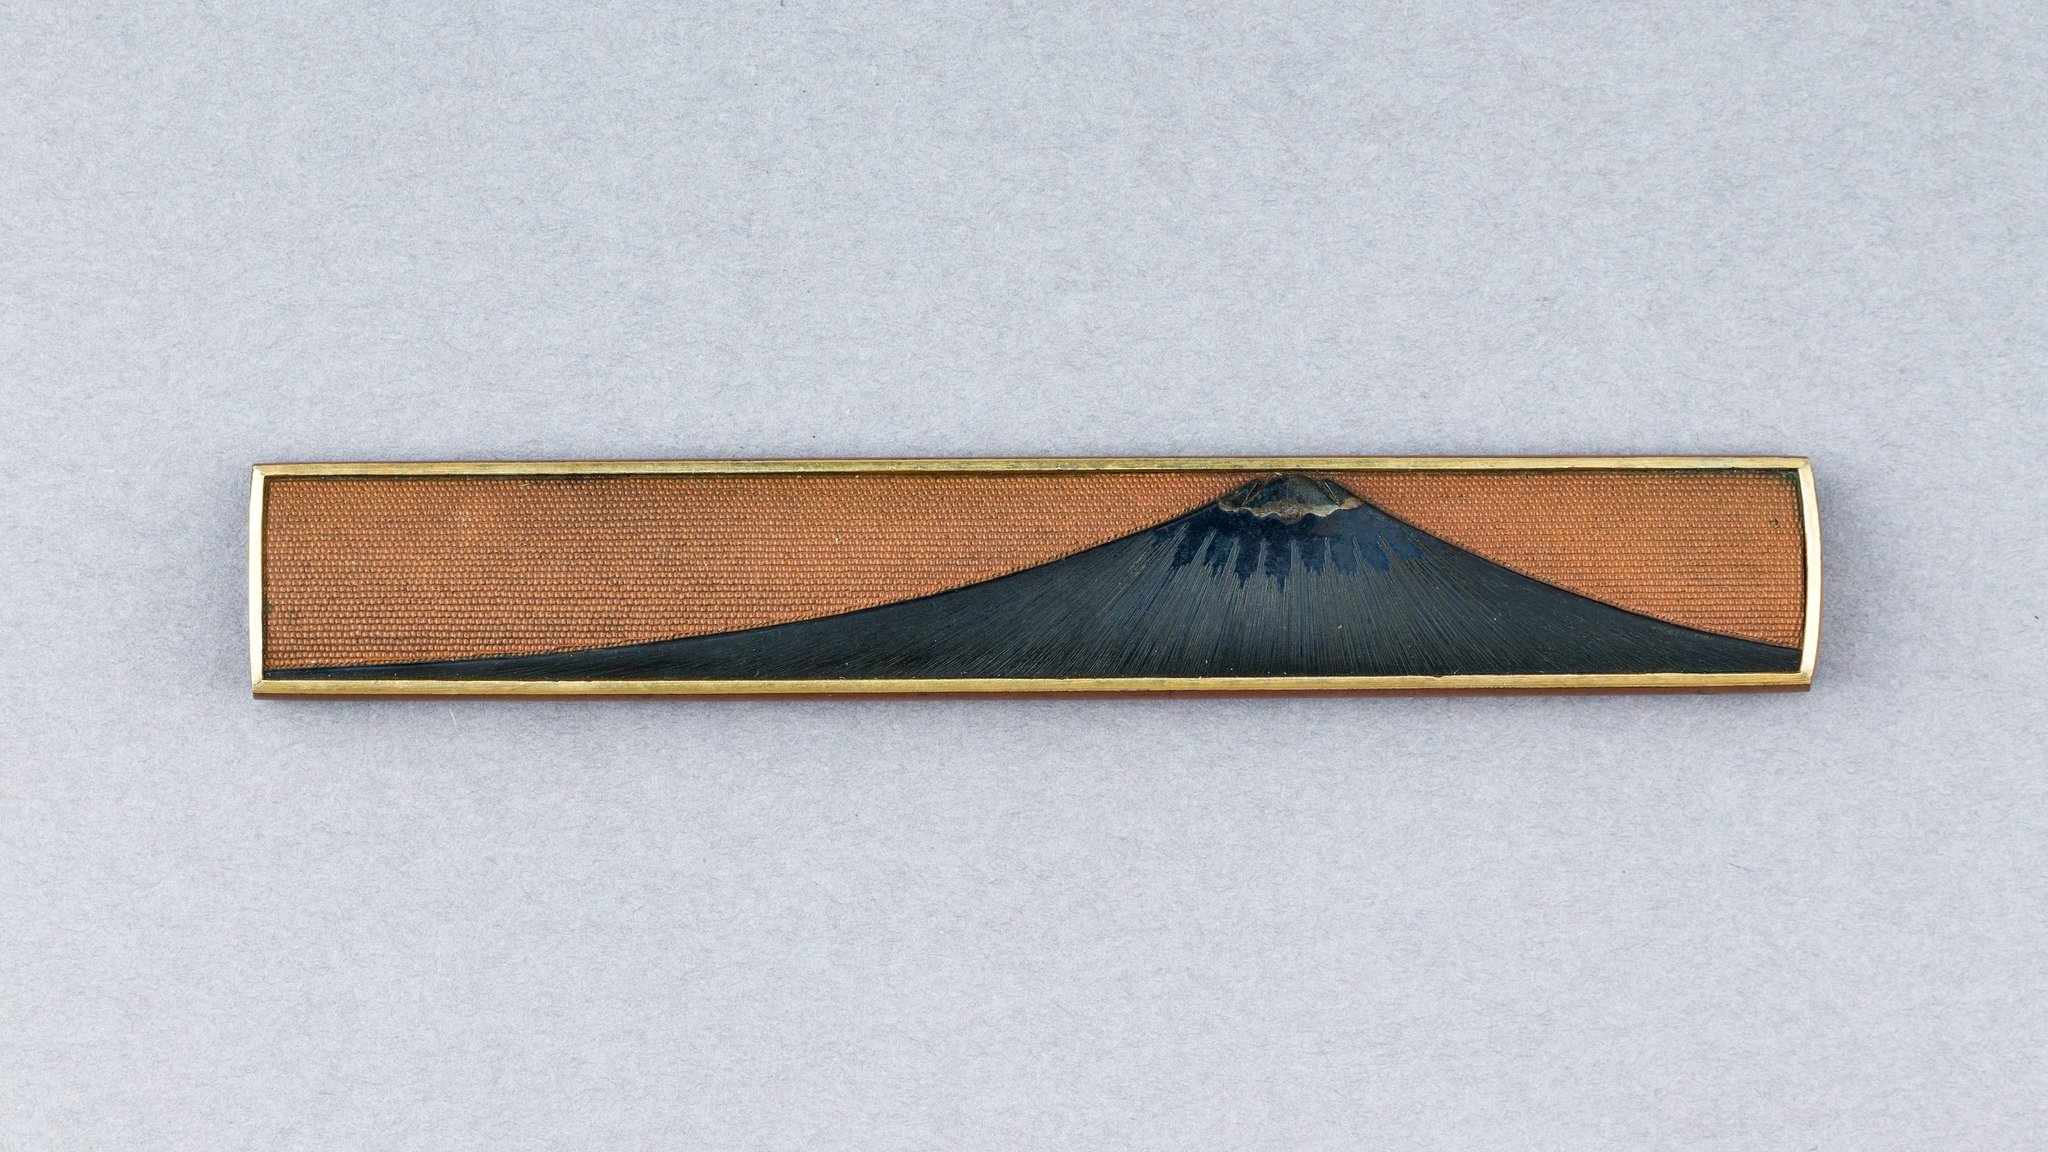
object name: knife handle kozuka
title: Knife Handle (Kozuka)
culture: japanese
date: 1615-1868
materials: copper, gold alloy, gold, silver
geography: japan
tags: mountains